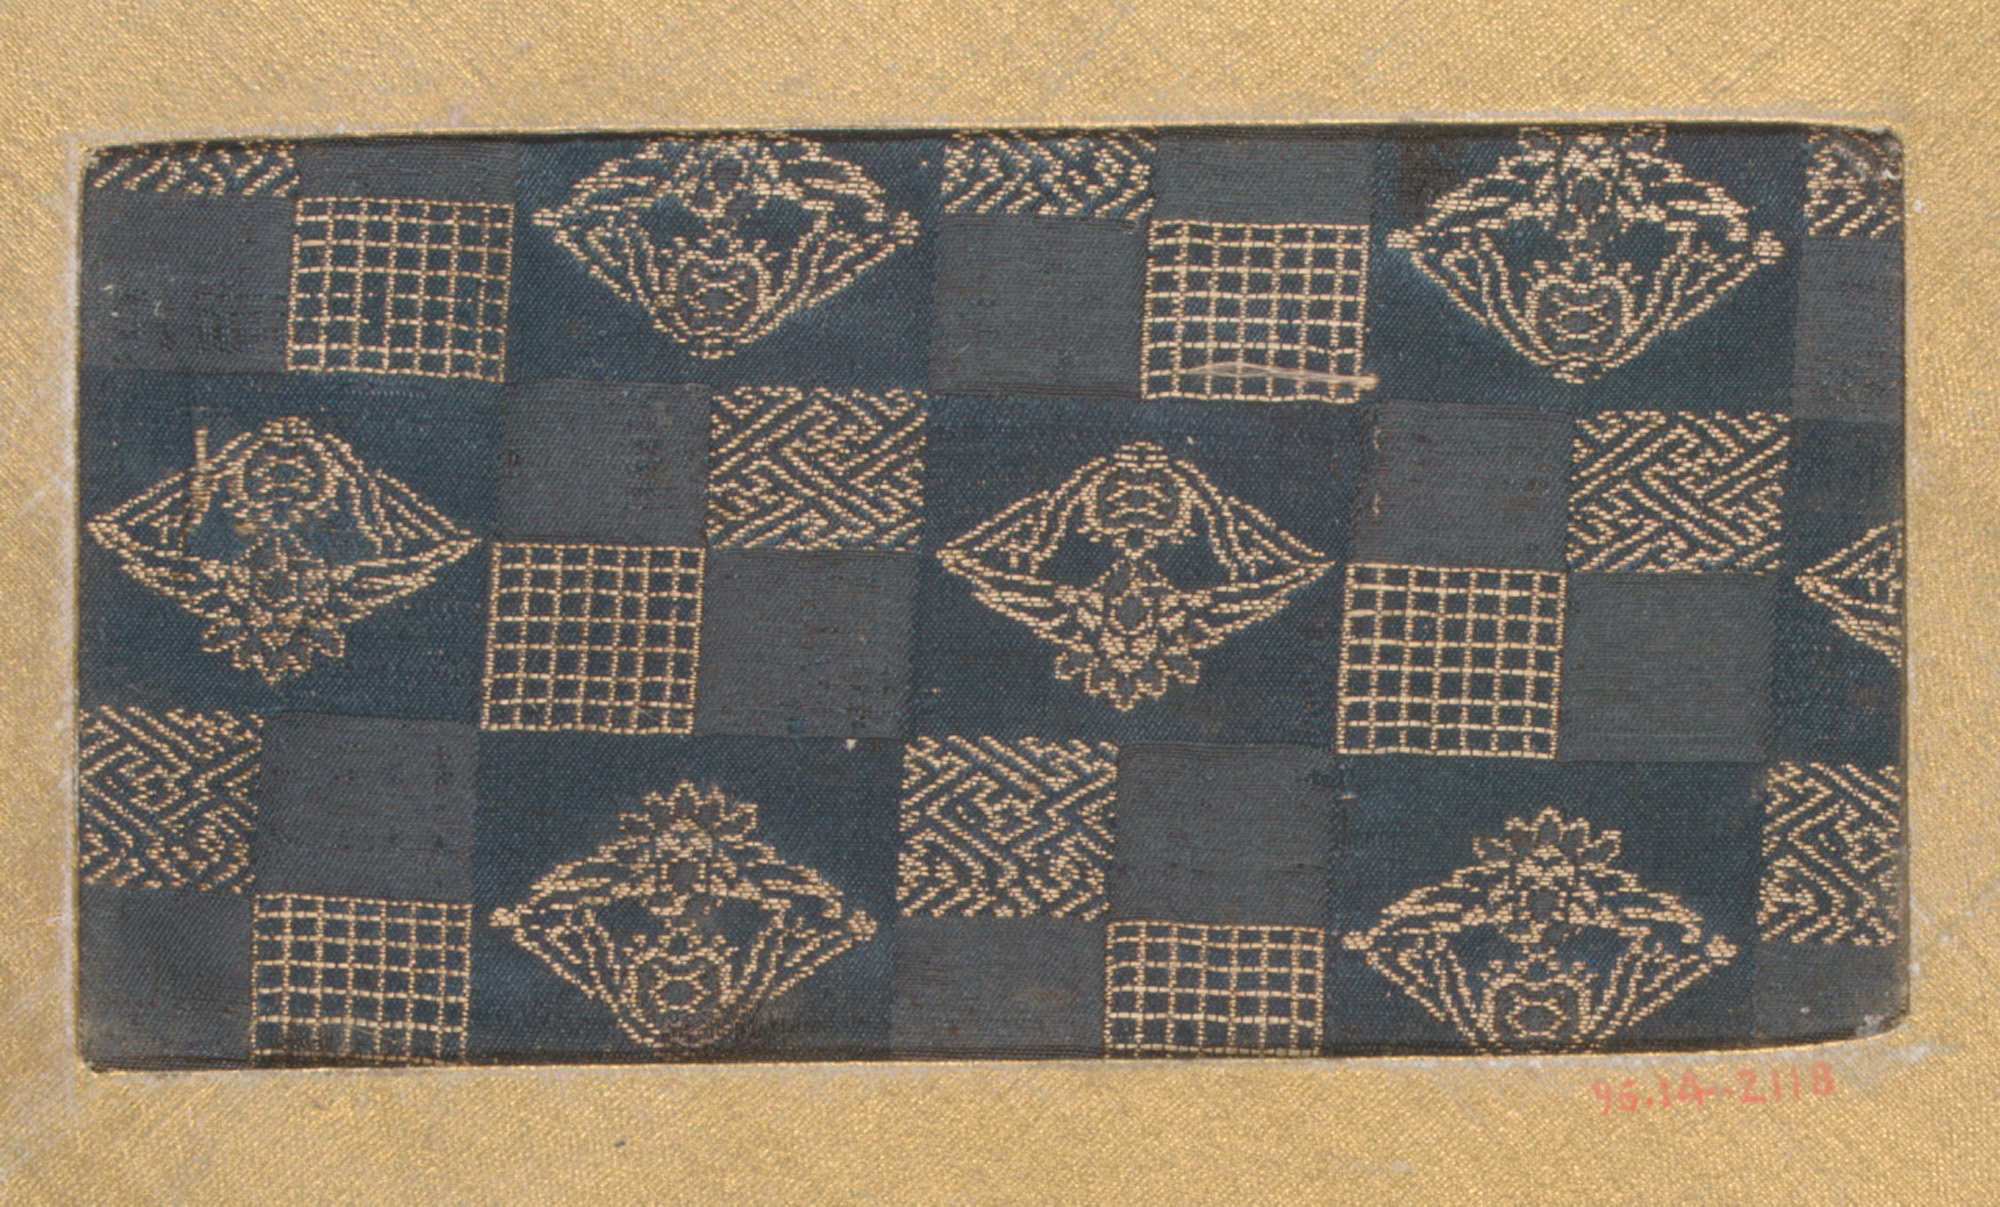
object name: piece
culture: japanese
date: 1701-1900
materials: silk